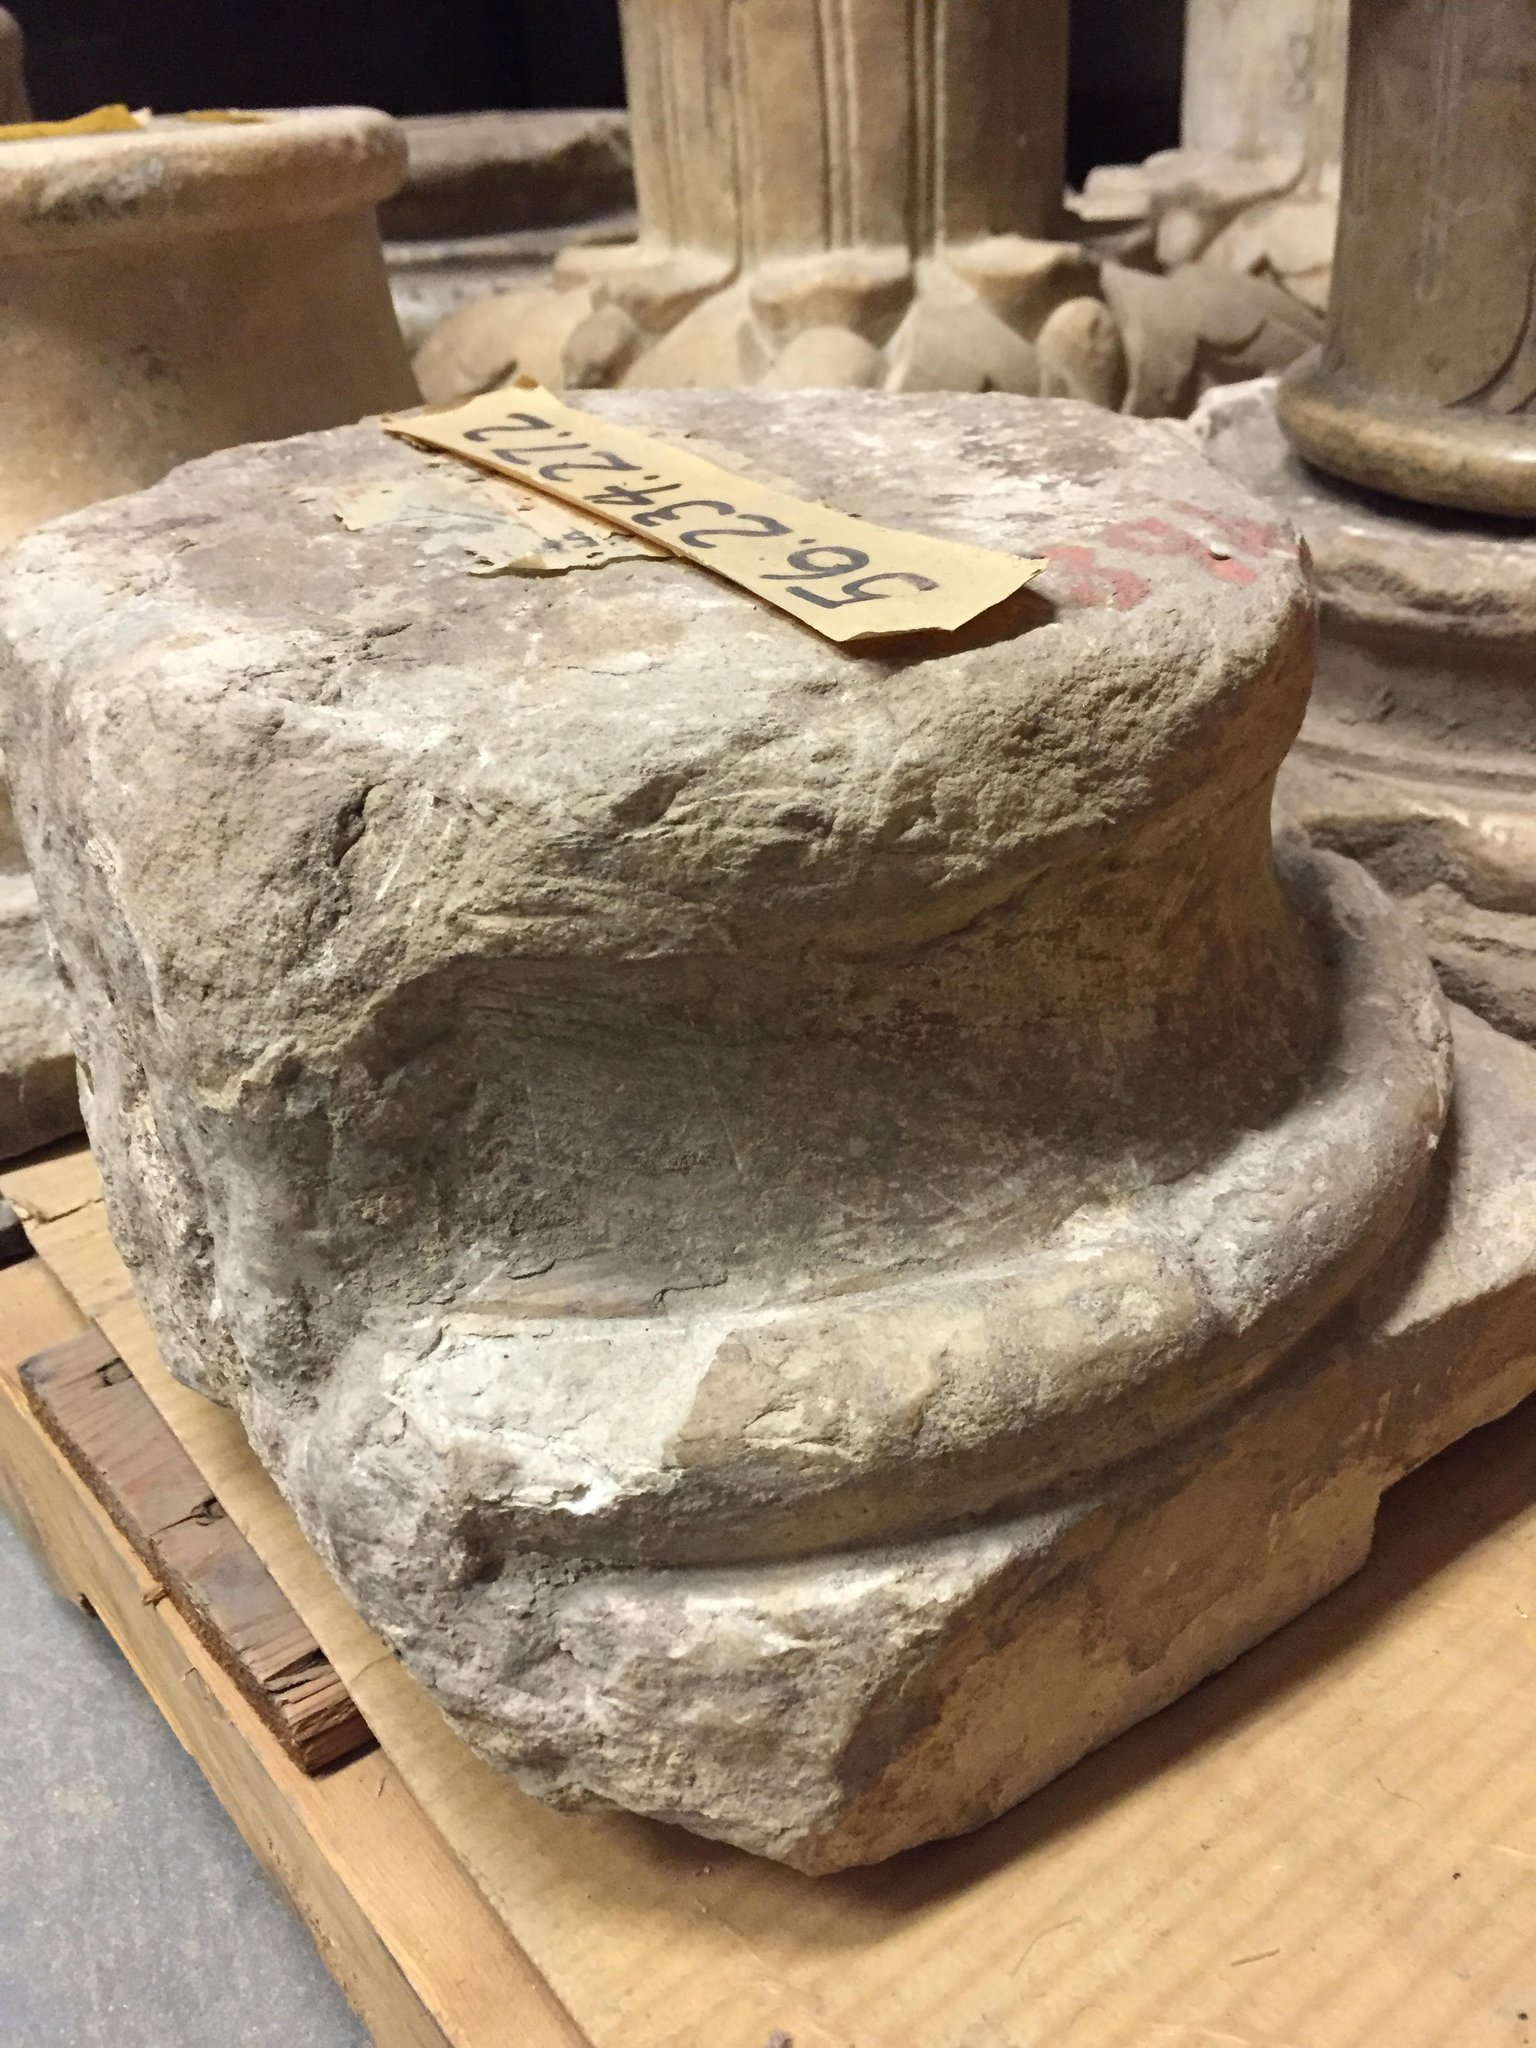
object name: plinth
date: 1301-1400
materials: marble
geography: spain